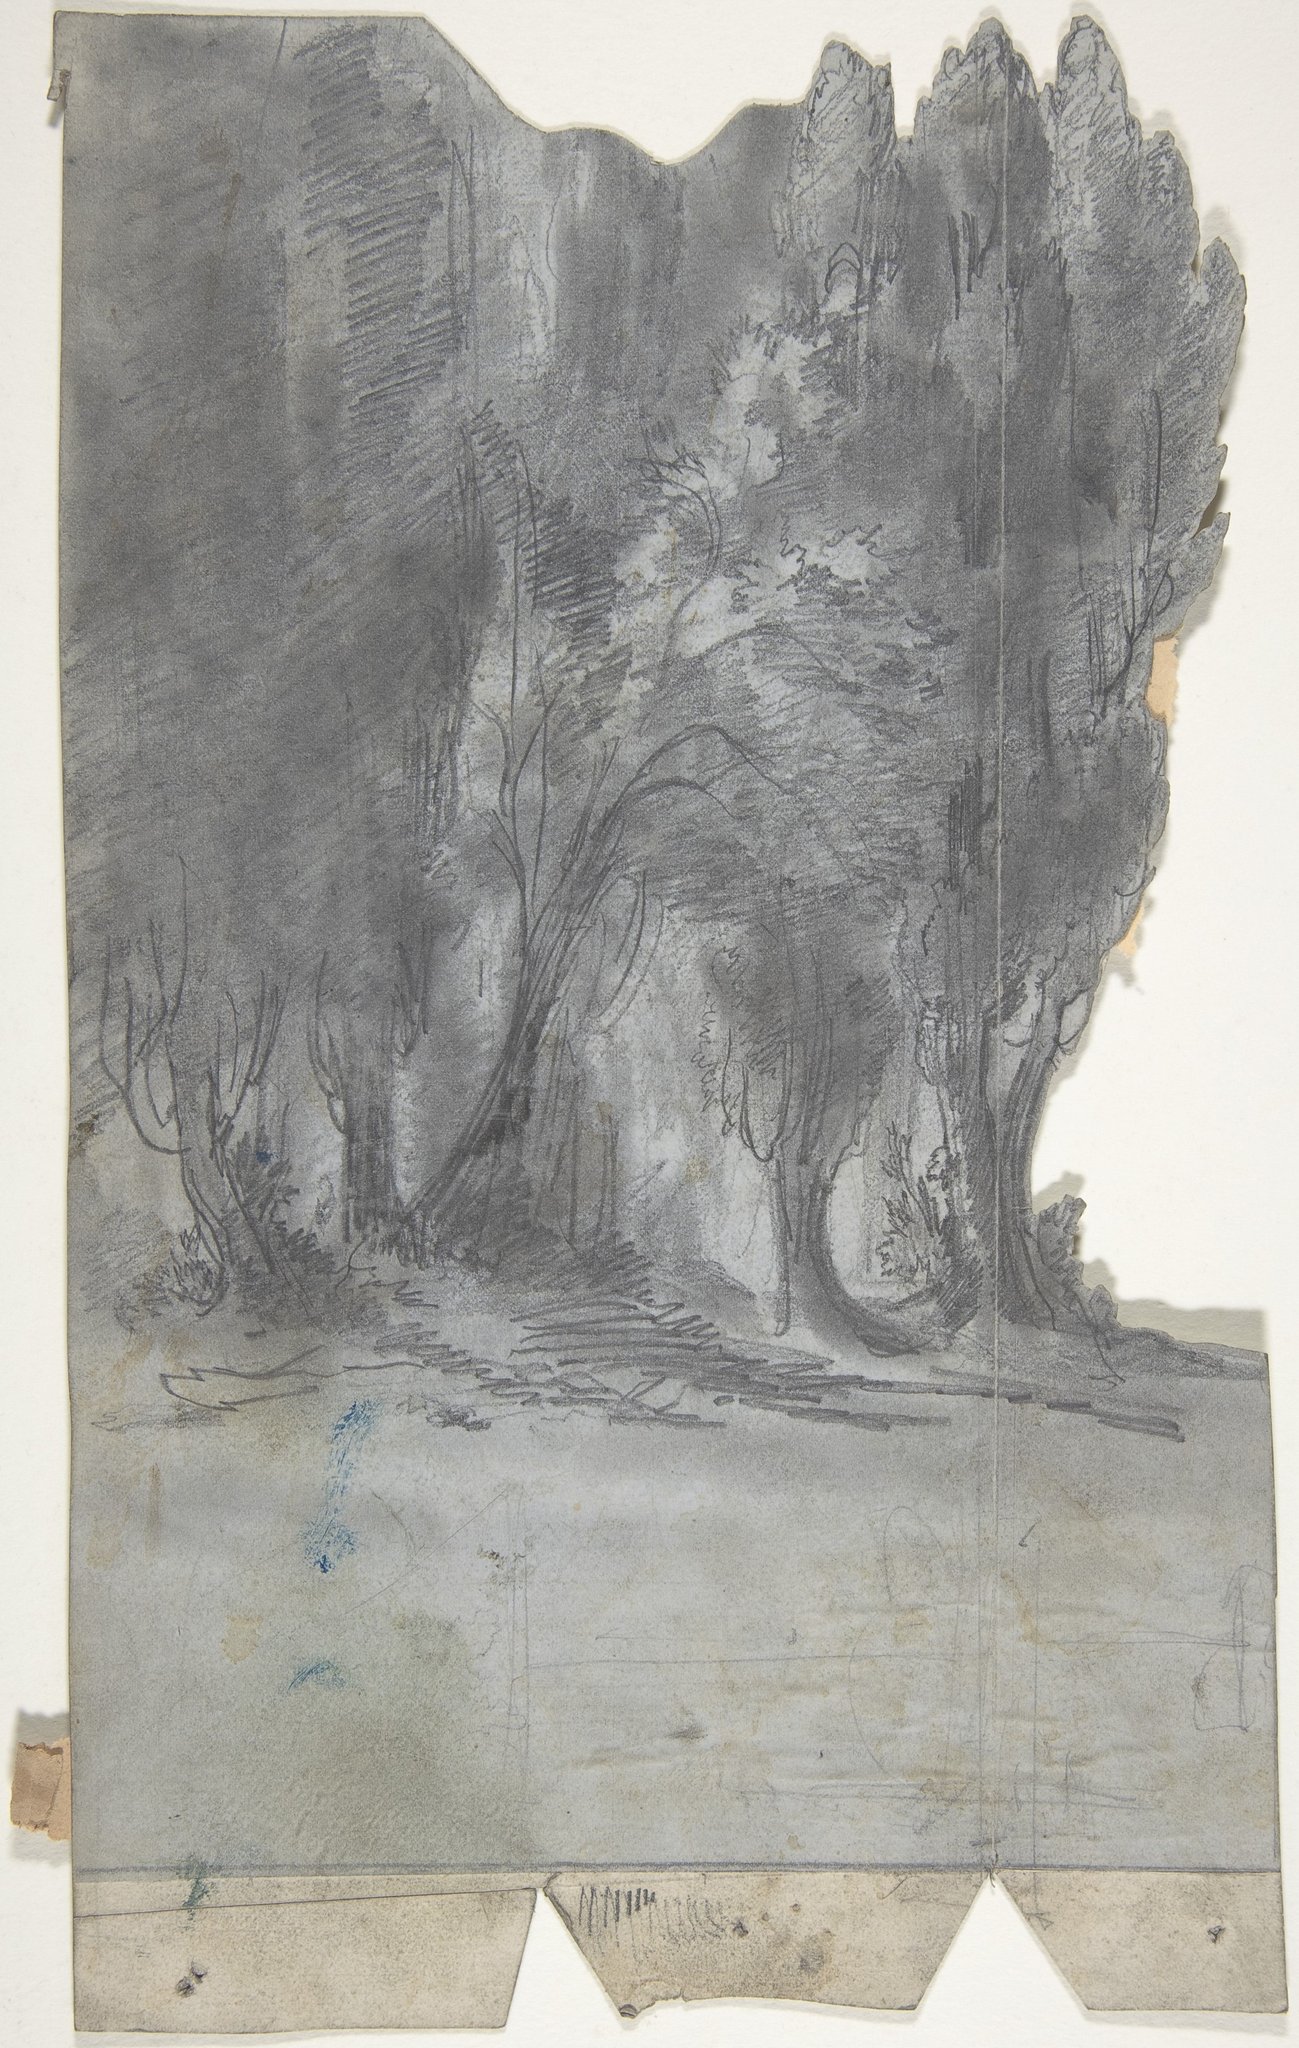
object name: drawing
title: Design for a Stage Set at the Opéra, Paris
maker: eugène cicéri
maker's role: artist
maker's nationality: french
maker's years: 1813-1890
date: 1830-1890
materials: graphite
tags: trees,stage design